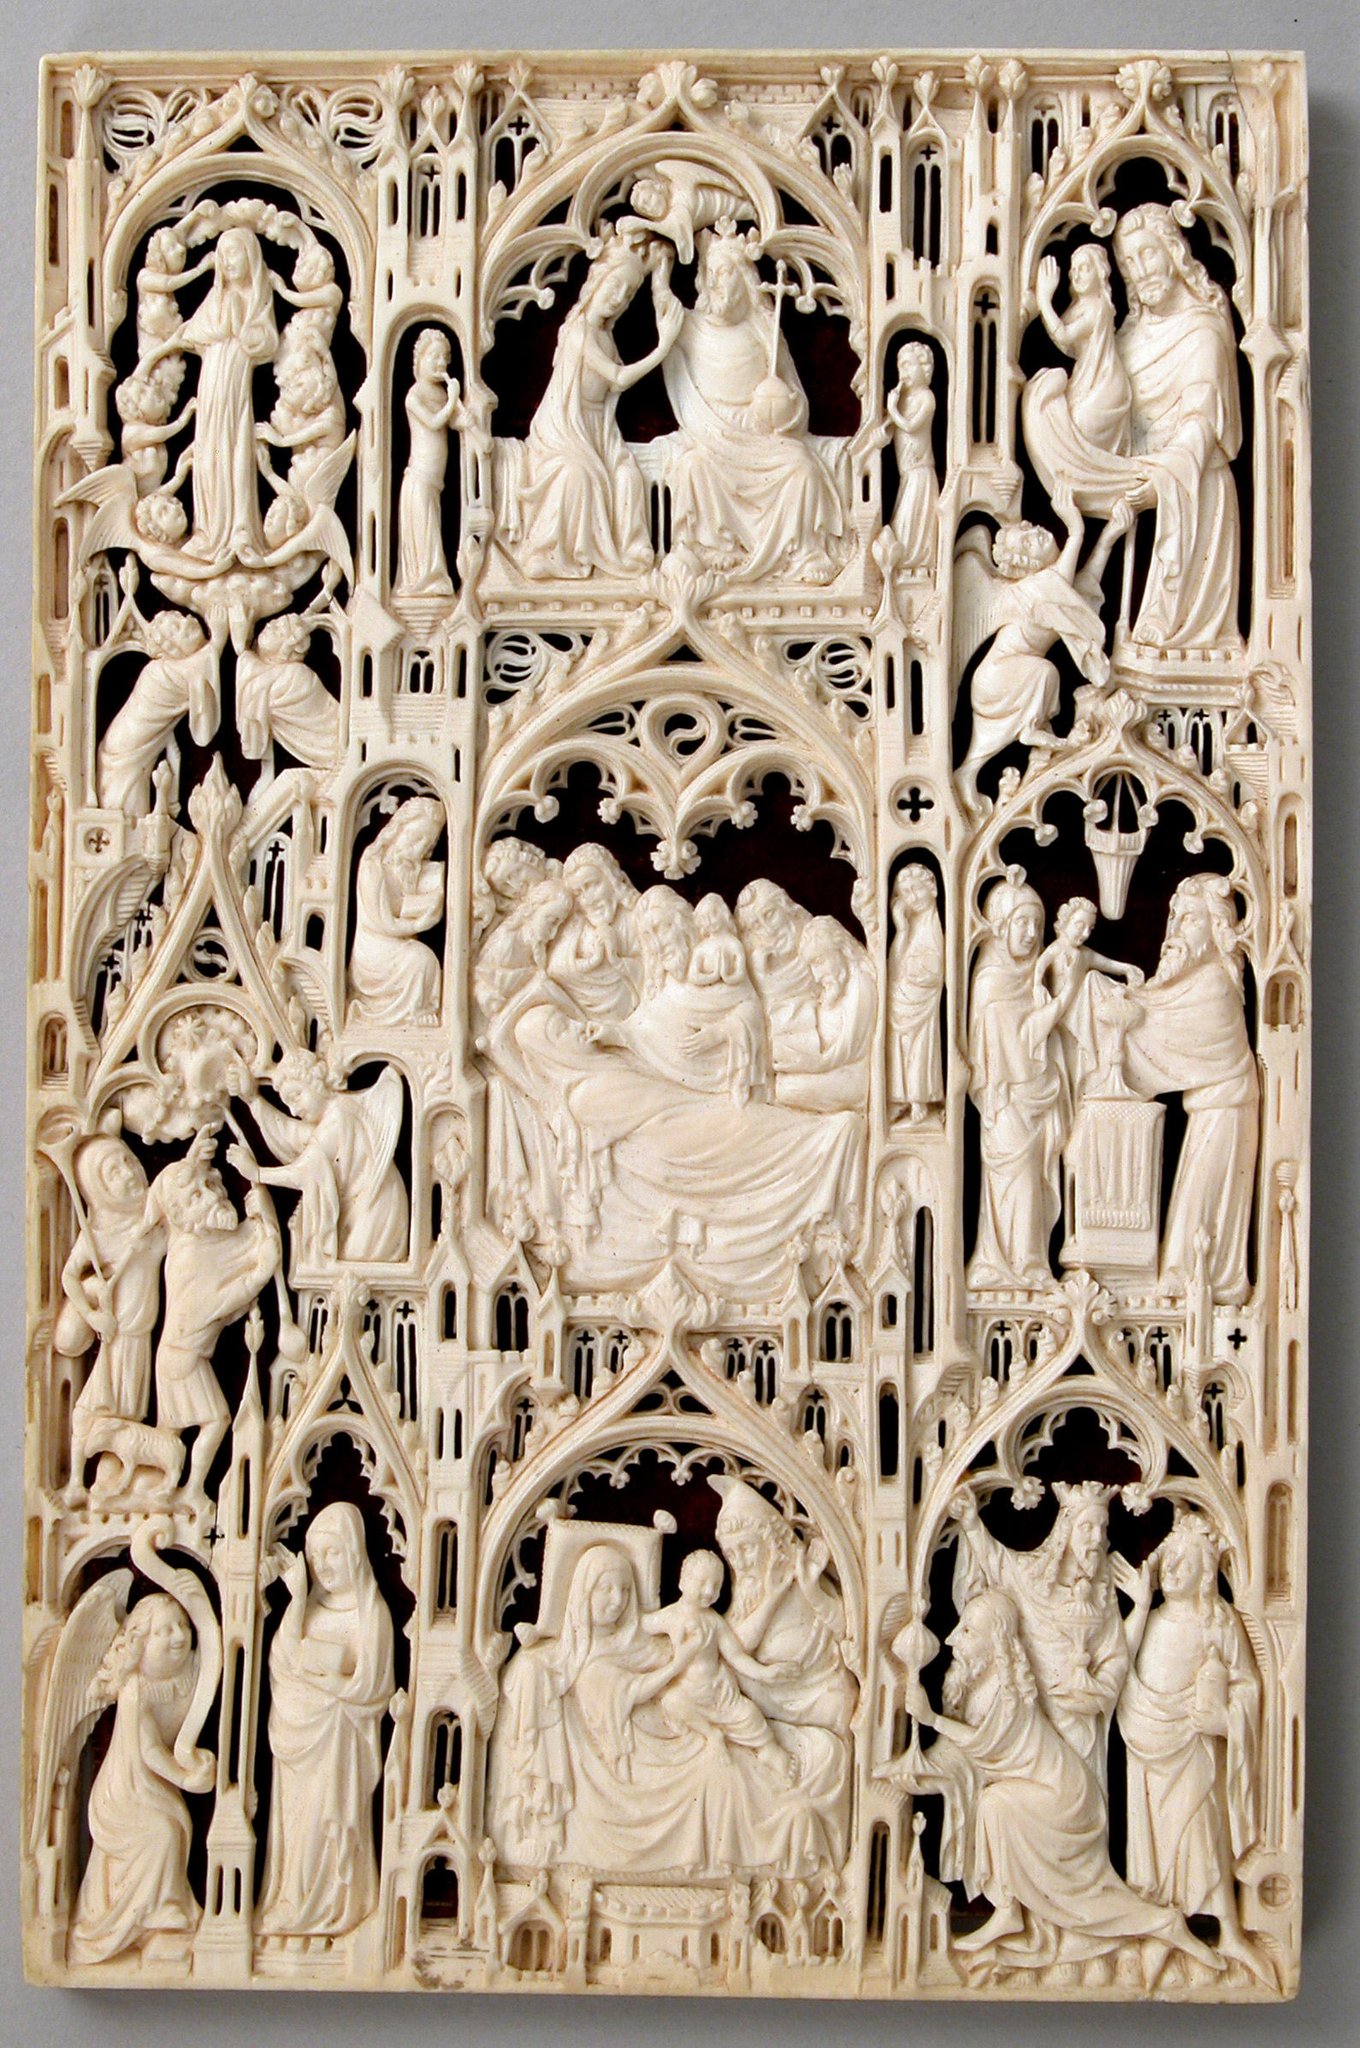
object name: diptych leaf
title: Leaf from a Diptych with the life of the Virgin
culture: british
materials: ivory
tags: christ,virgin mary,annunciation